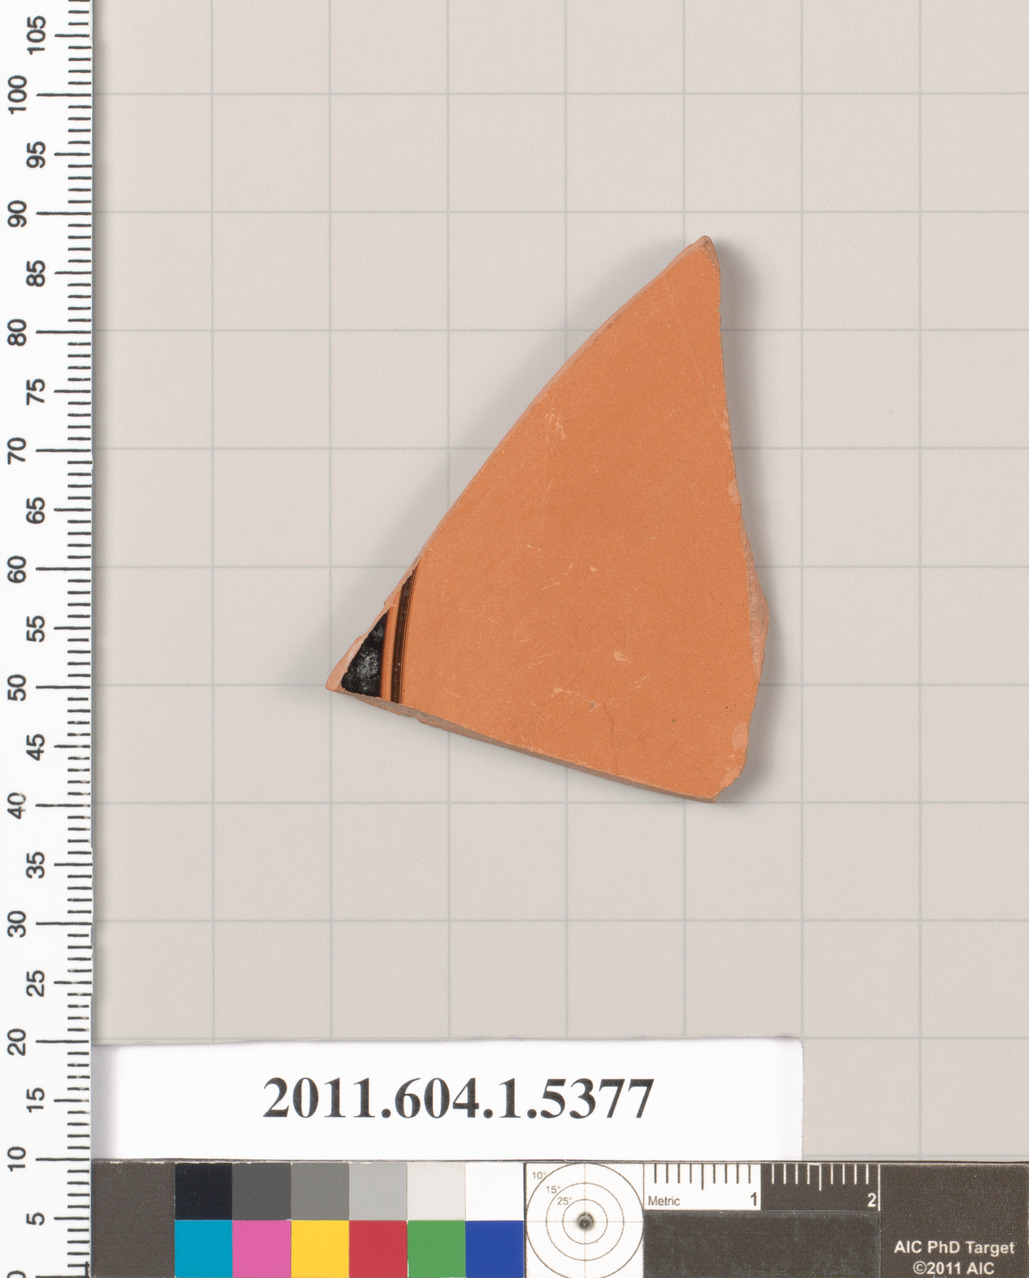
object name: kylix fragment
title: Terracotta fragment of a kylix (drinking cup)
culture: greek, attic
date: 500-480 BCE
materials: terracotta